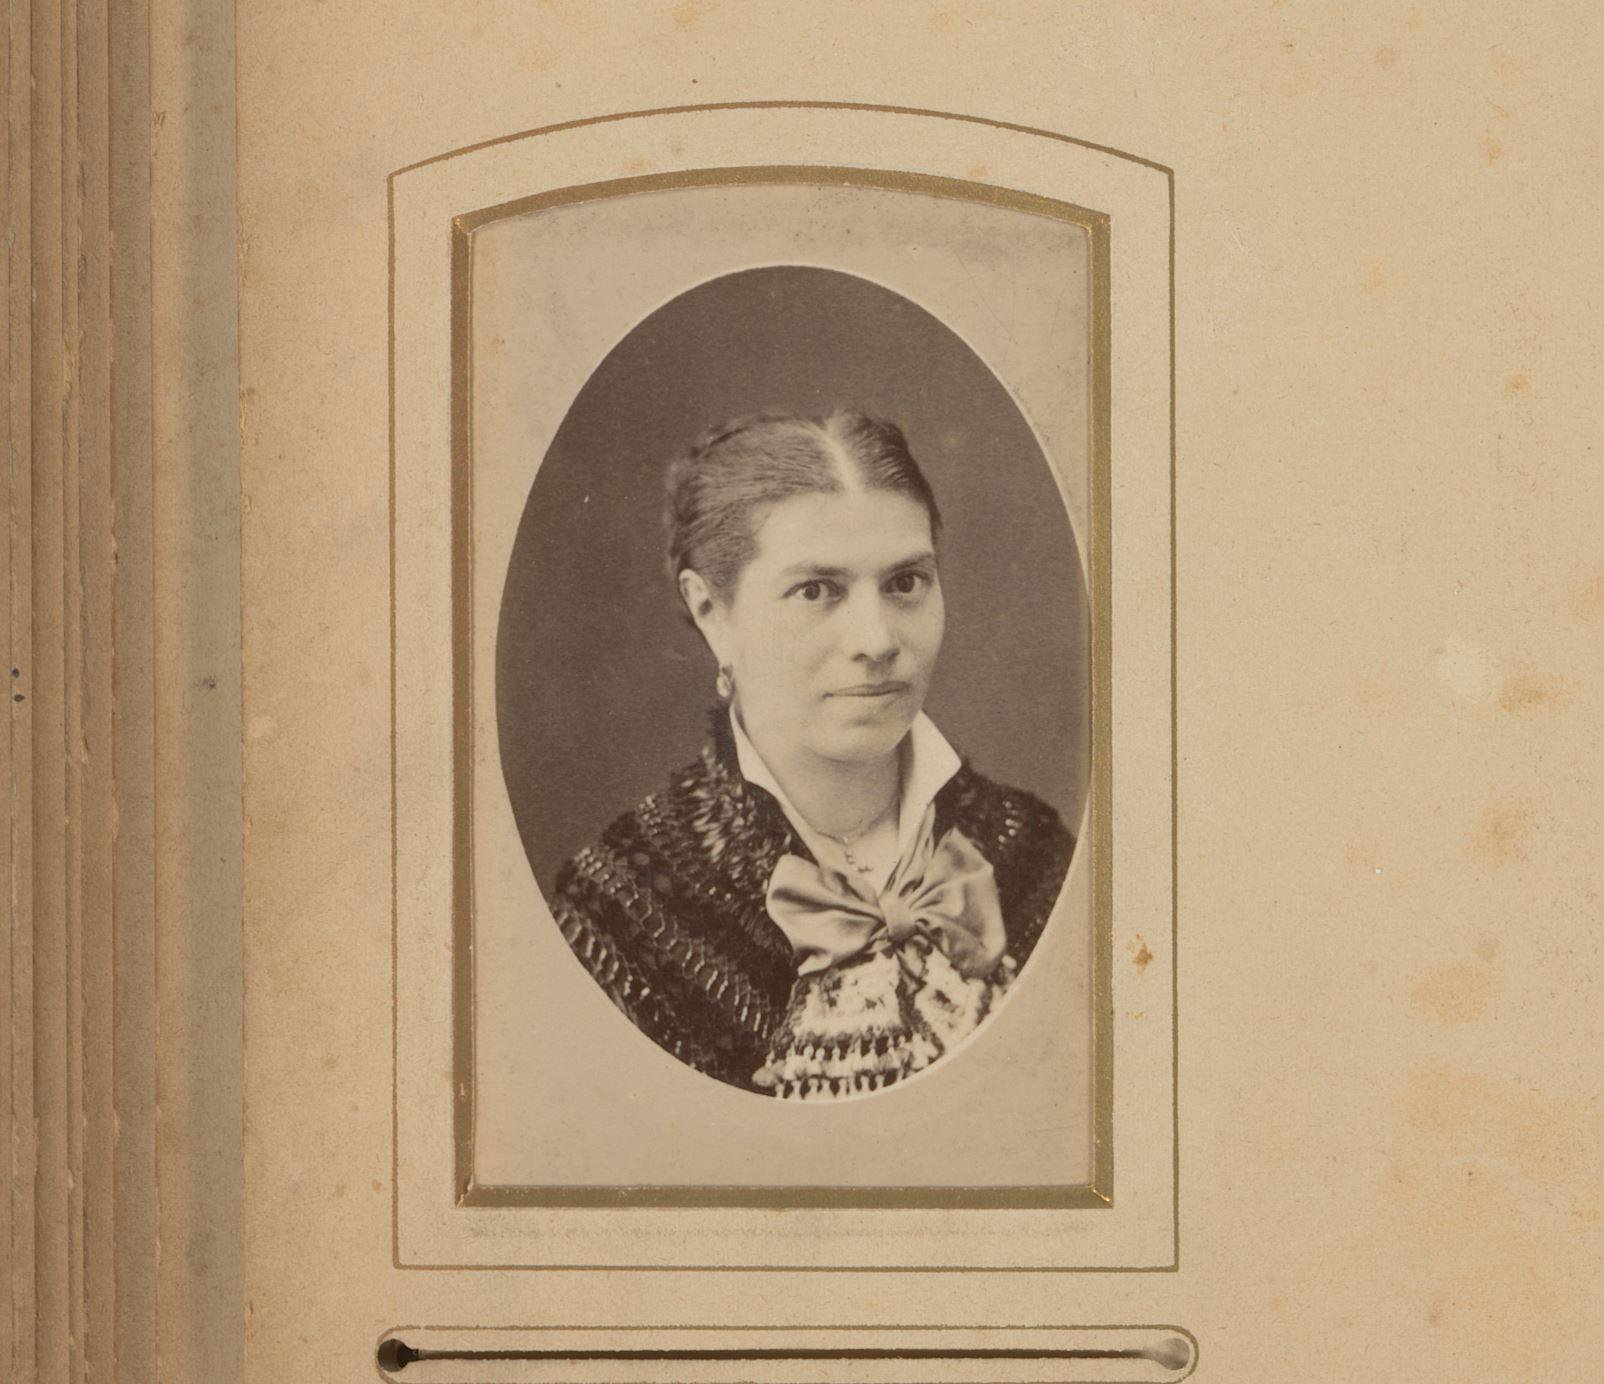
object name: carte de visite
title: Portret van een vrouw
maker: egide linnig-quveliers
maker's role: fotograaf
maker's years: 1844-1908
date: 1875-1899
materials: cardboard, celluloid, photographic support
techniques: albumen print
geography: antwerp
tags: historical persons - bb - woman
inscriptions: inscription: ‘E. Linnig-Quveliers/ ARTISTE PHOTOGRAPHE/ 20, Rue de la Commune/ Anvers/ Les Clichés sont conservés’